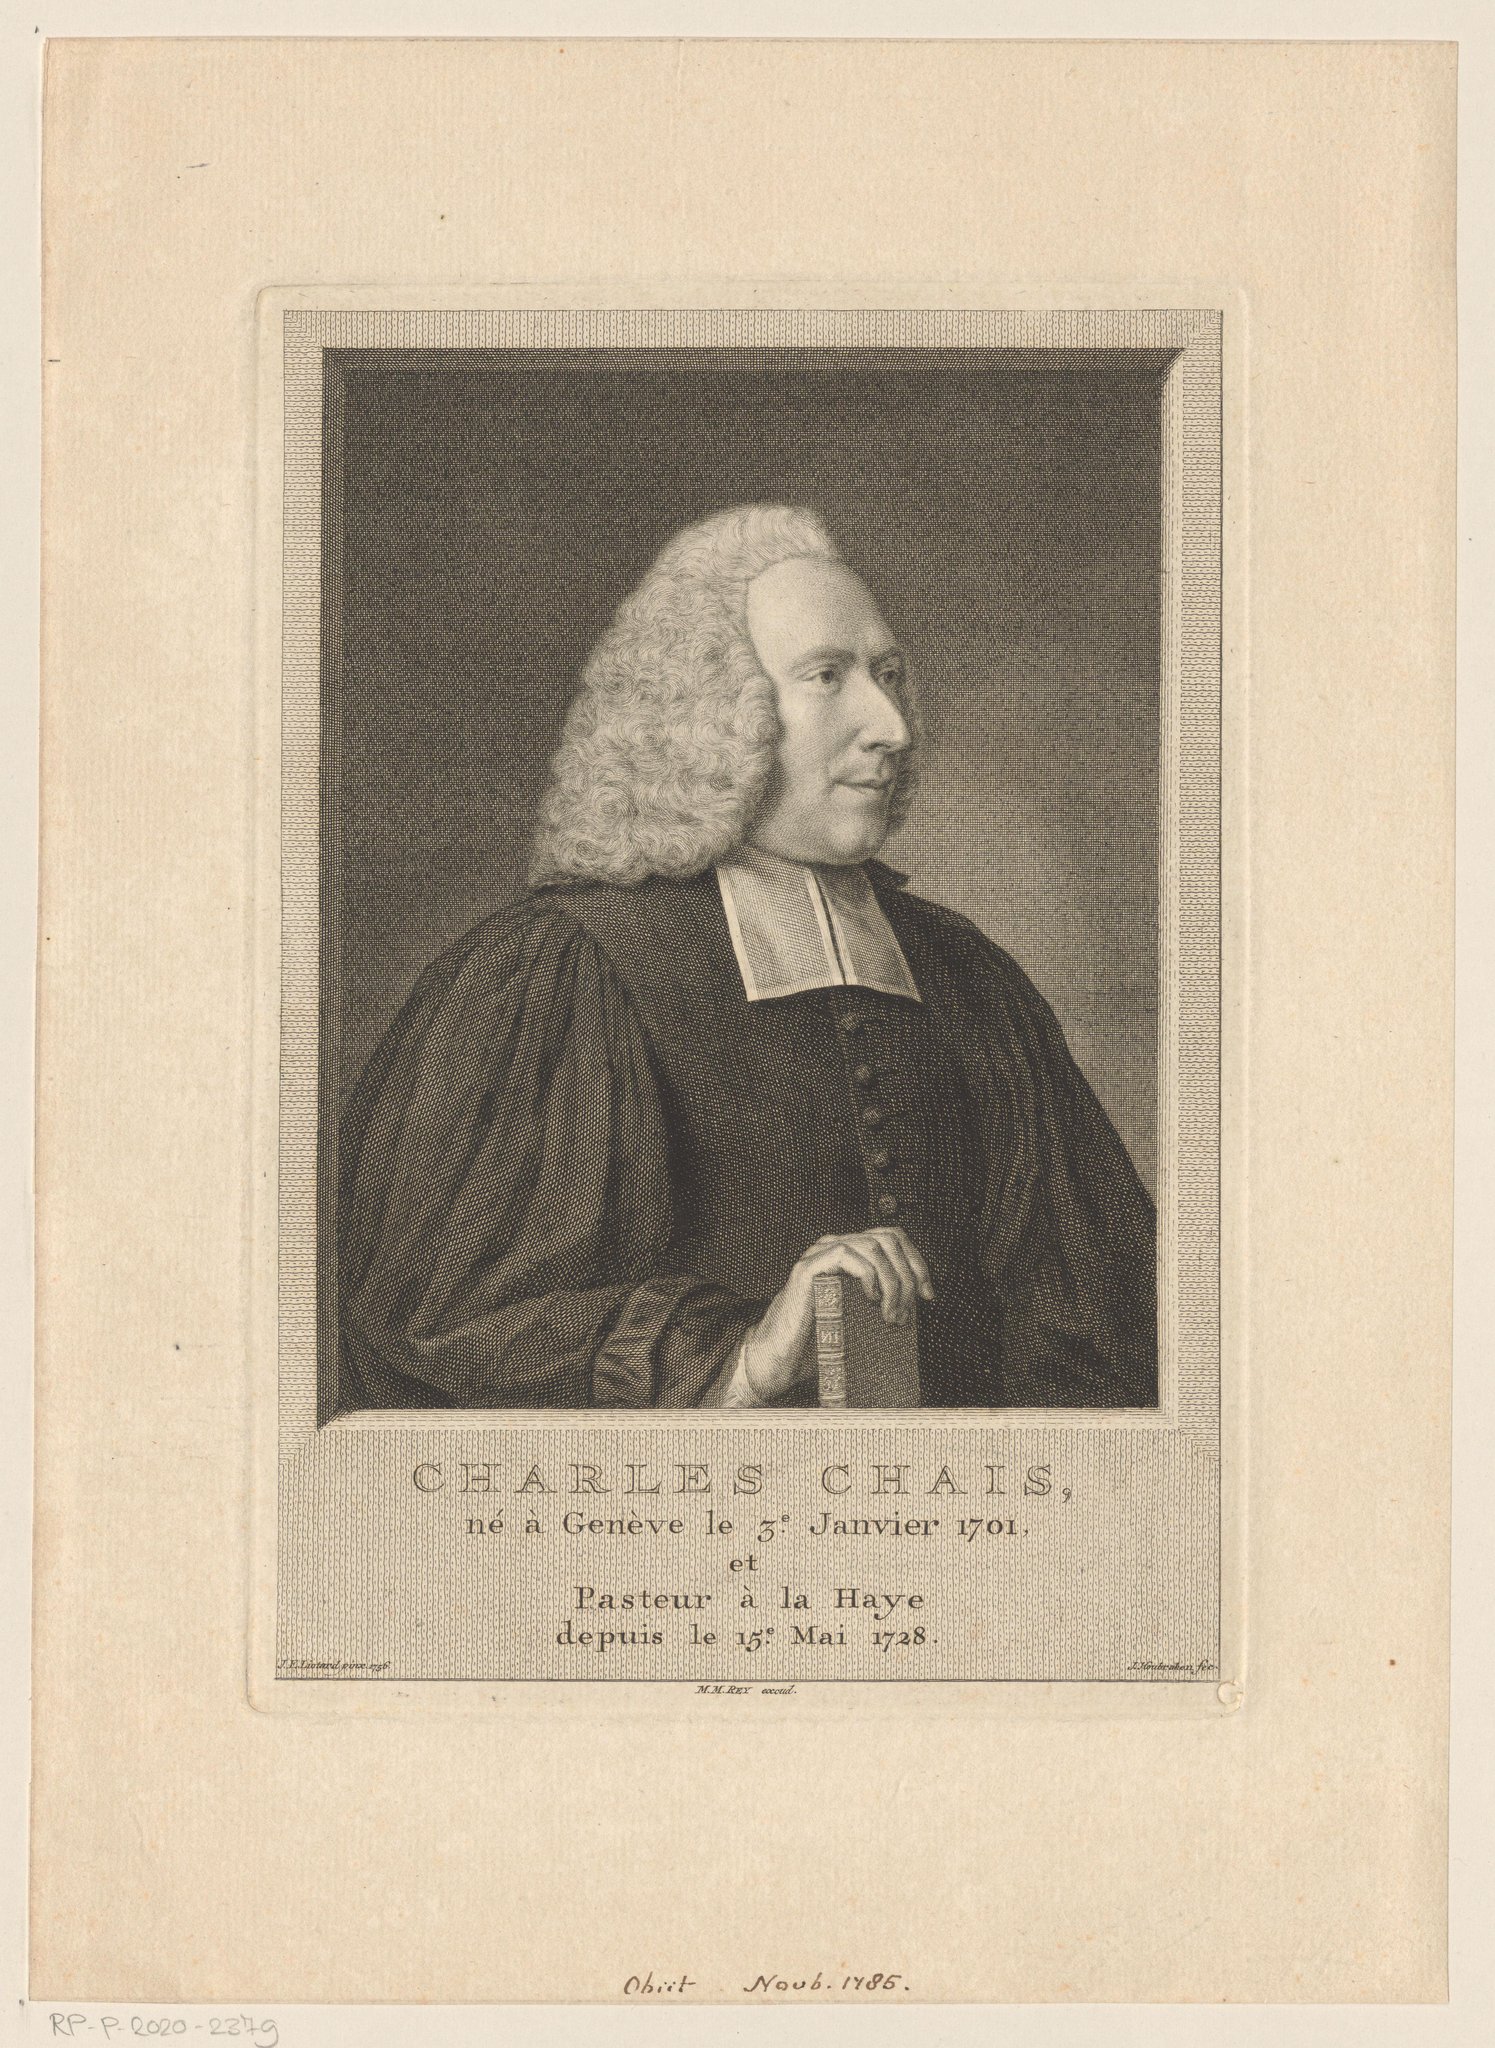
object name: print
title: Portret van Charles Chais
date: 1756-1779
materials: paper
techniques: engraving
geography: amsterdam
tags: the hague, historical persons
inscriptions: check stamp: Lugt 1120